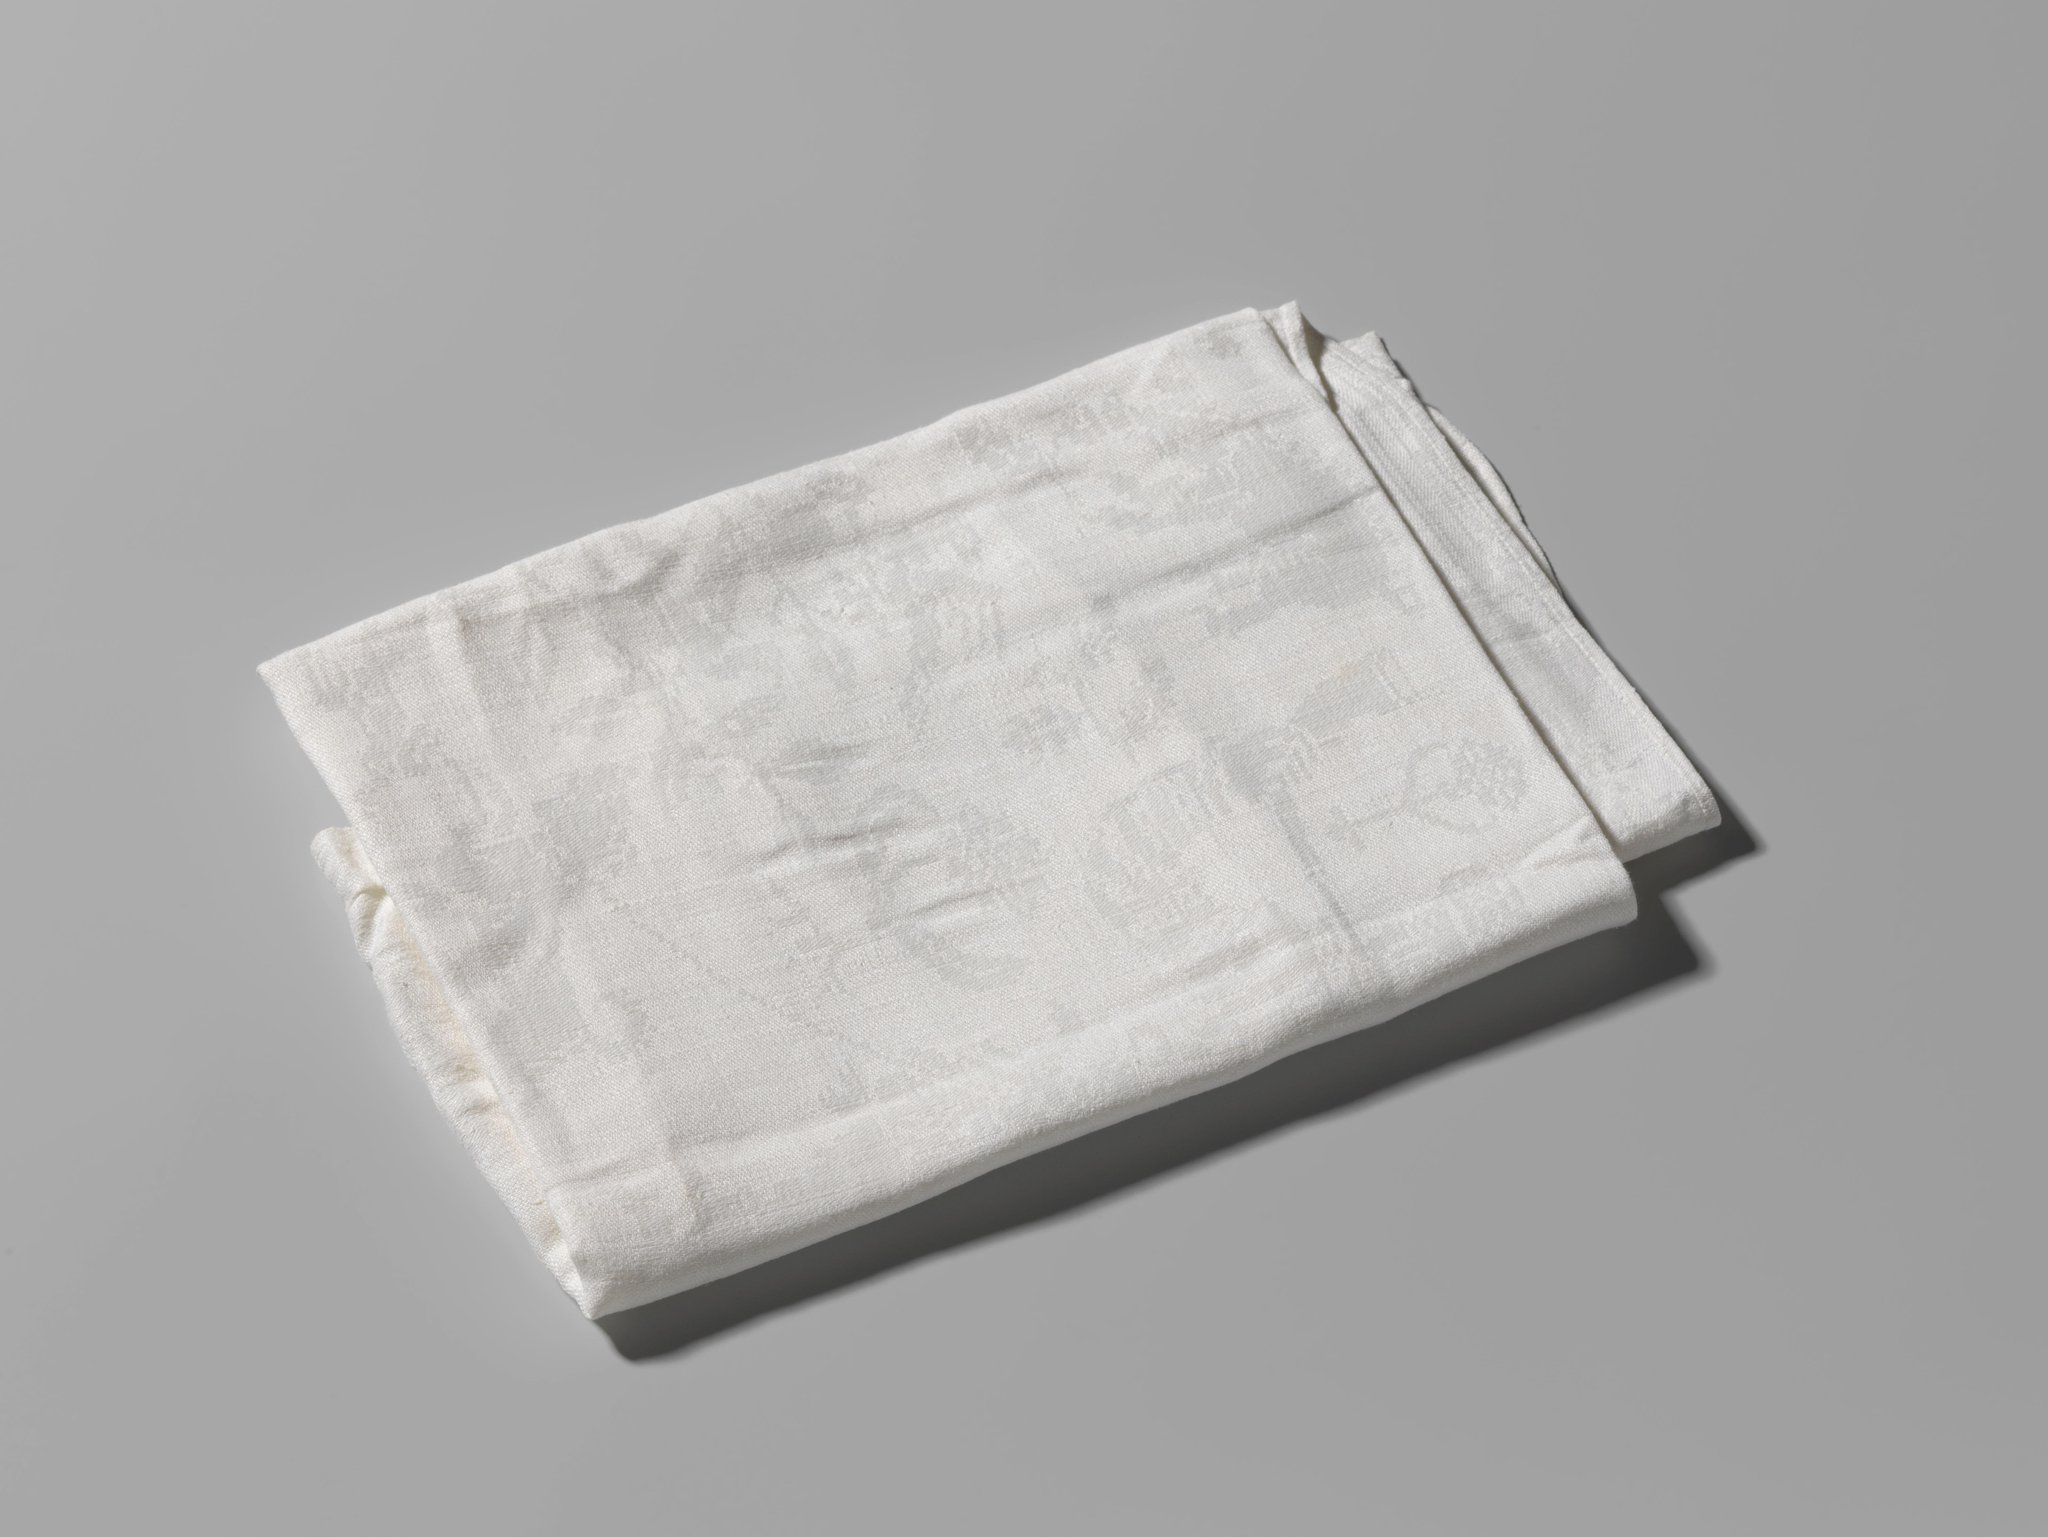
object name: napkin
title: Servet met ingeweven jachttafereel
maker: Anonymous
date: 1600-1625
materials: linen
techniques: damask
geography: southern netherlands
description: Servet van wit linnendamast, behorende bij tafellaken met jachttafereel. Merk nr.: 913. In blauw gestikt: *22.